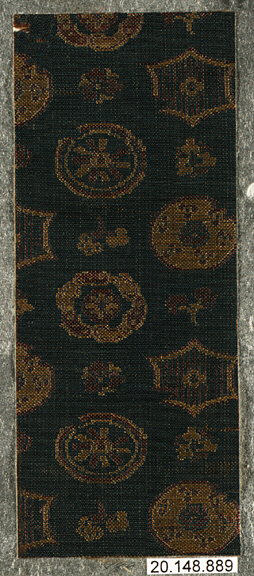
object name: piece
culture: chinese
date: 1701-1800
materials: silk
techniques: compound weave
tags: flowers